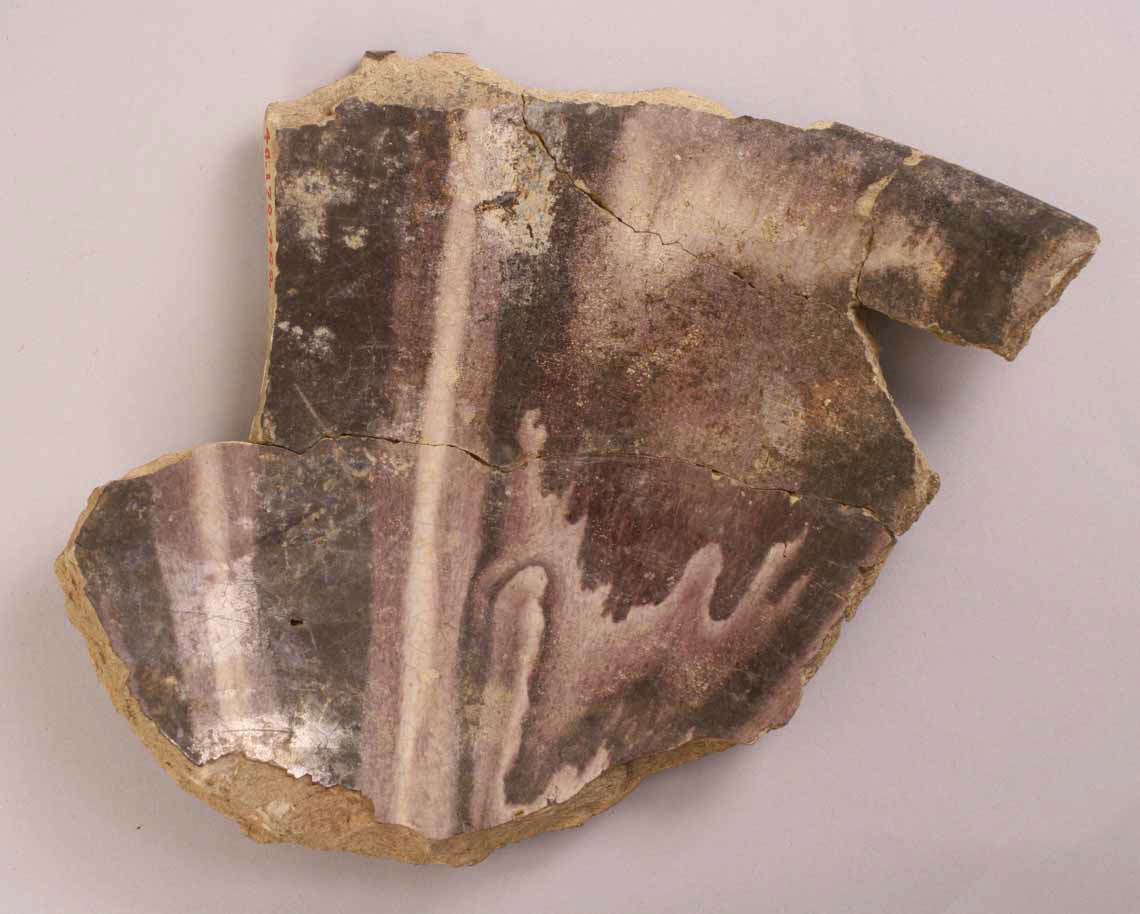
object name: fragment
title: Ceramic Fragment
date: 801-900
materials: earthenware, glaze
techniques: polychrome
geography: iran